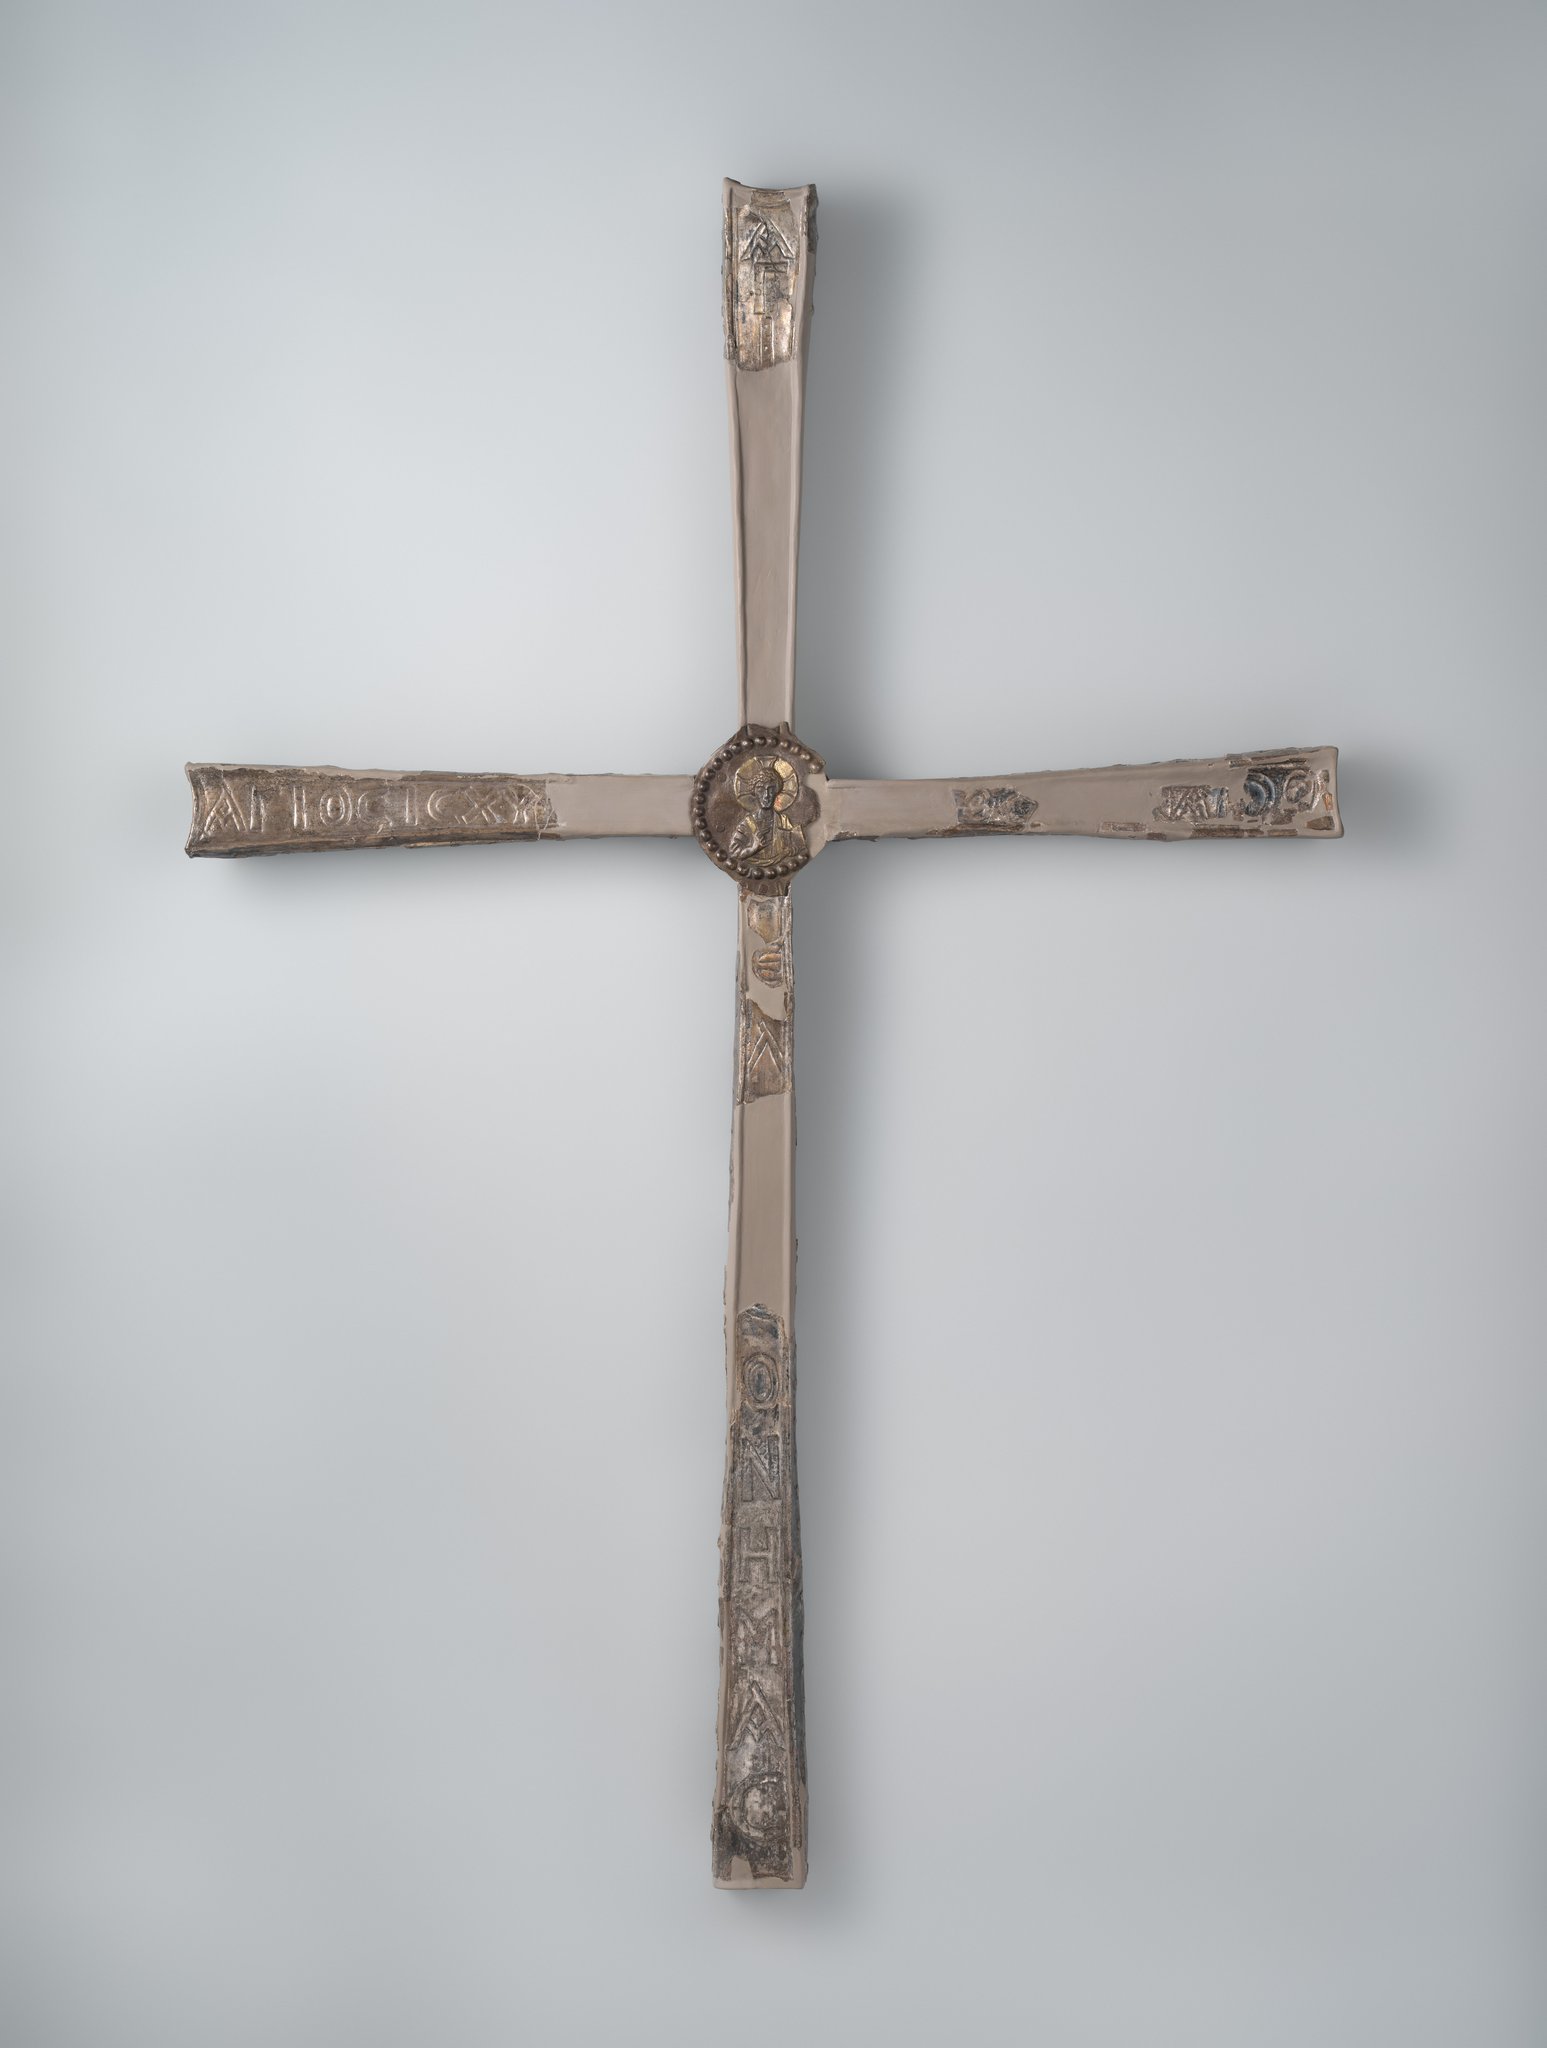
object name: cross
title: Processional Cross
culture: syrian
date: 501-600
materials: silver, wood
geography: antioch or kaper koraon (?)